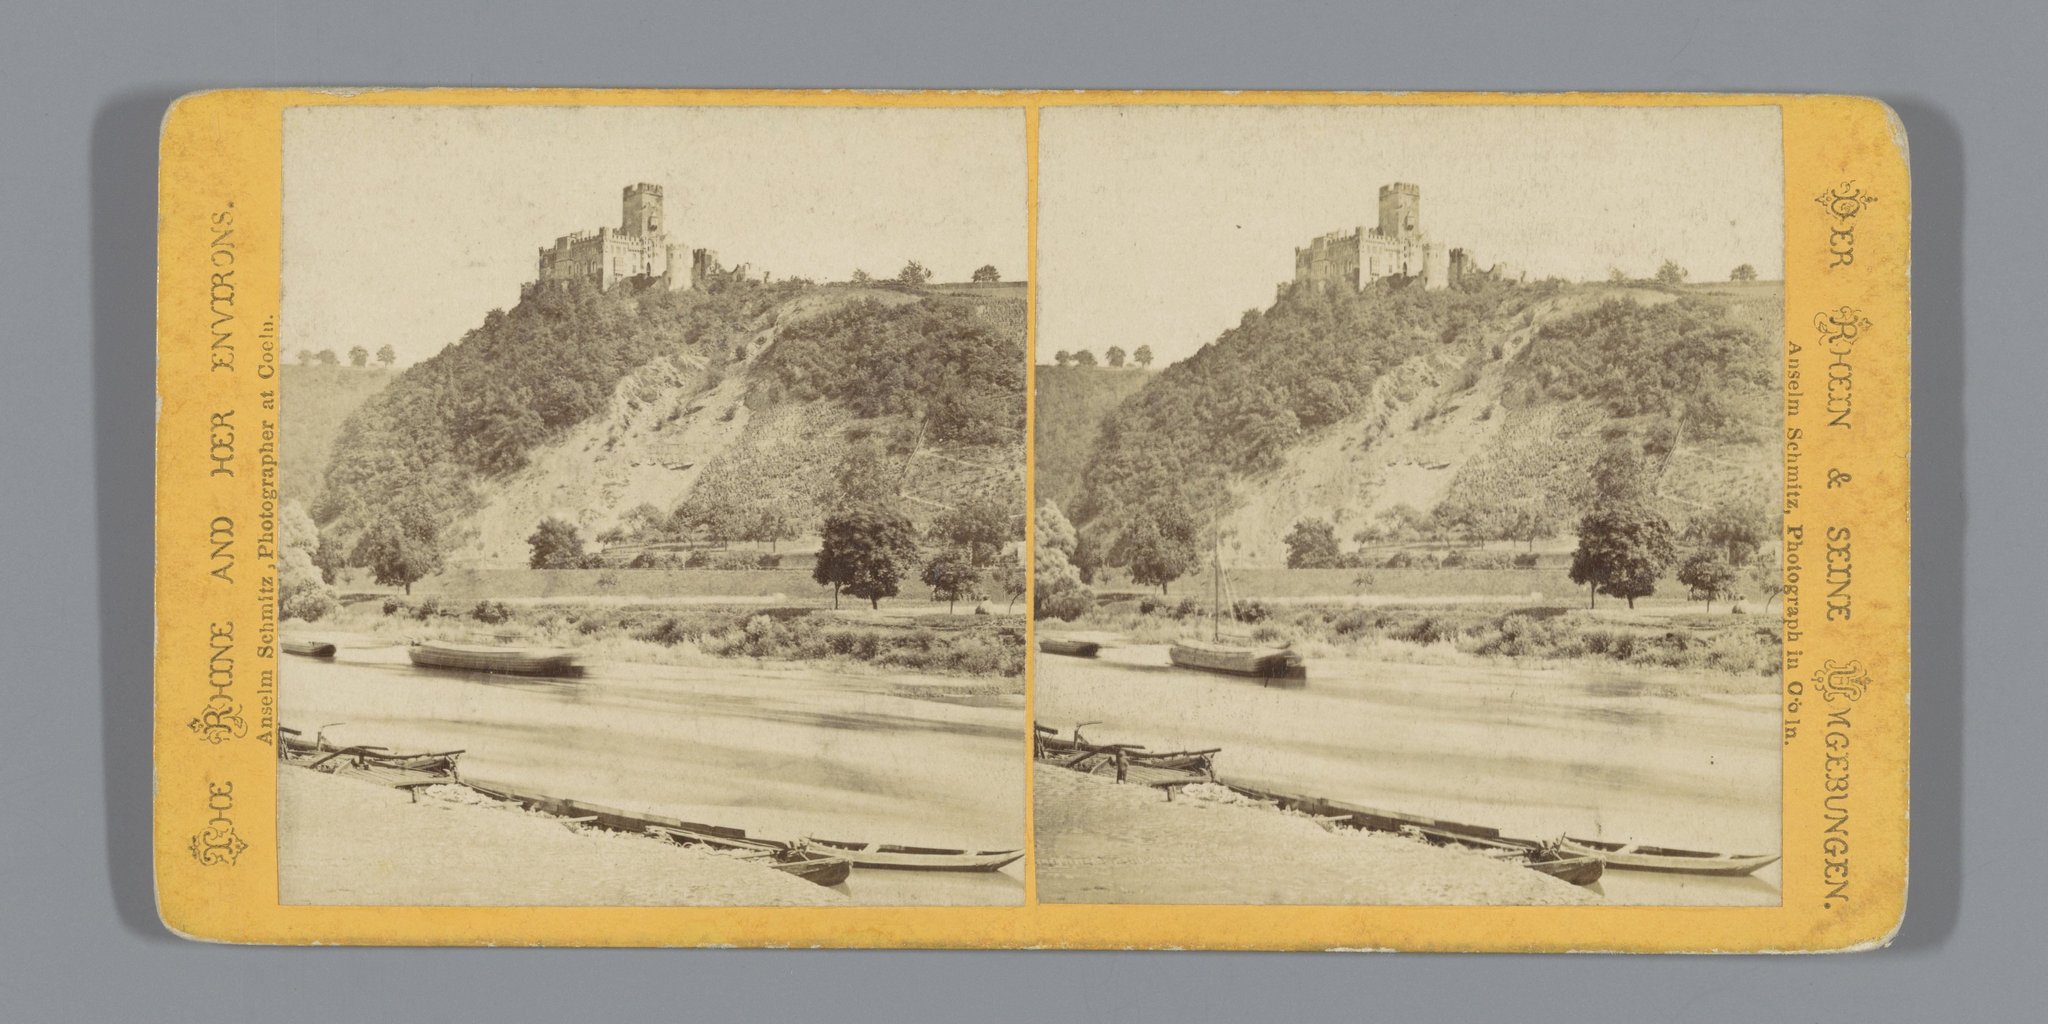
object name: stereograph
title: München, Bavaria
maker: hermann manz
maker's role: fotograaf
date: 1860-1880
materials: cardboard, photographic support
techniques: albumen print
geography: munich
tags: sculpture, façade (of house or building)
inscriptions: inscription: ‘Kgl. Hofkunsthandlung von Hermann Manz in München’, number: ‘Nr. 19’